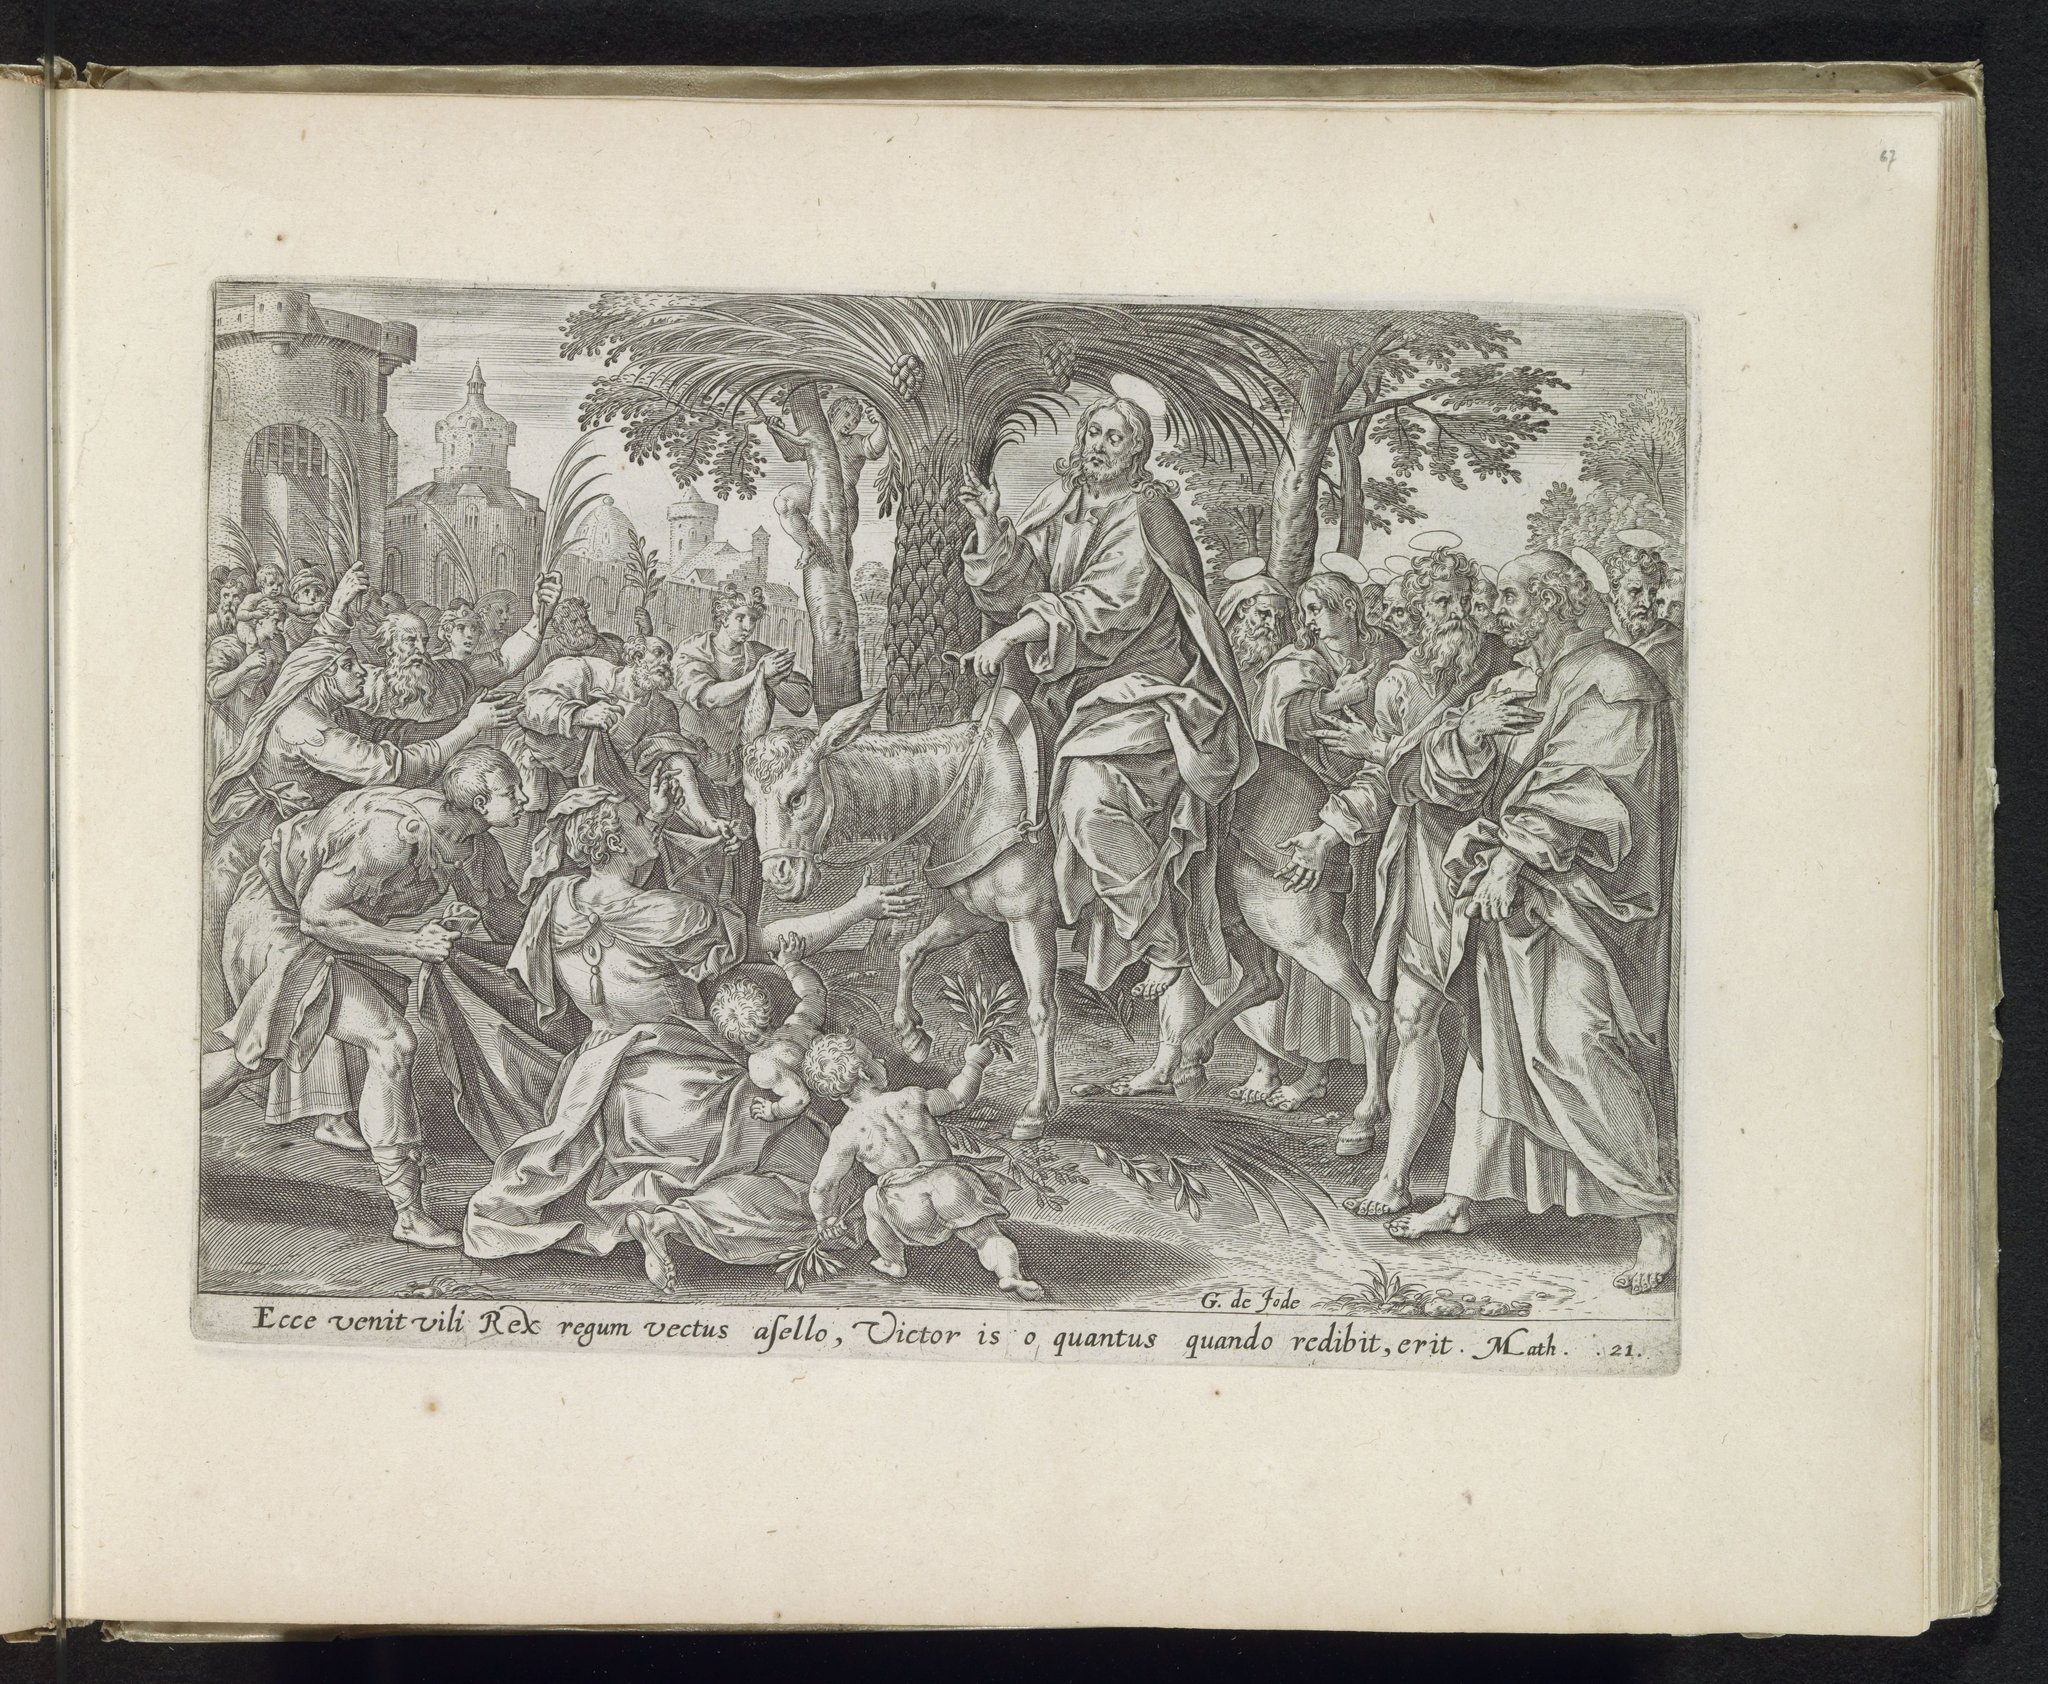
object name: print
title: Intocht in Jeruzalem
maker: gerard de jode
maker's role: draughtsman, print maker, publisher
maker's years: 1508-1591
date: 1585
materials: paper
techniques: engraving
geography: antwerp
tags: entry into jerusalem: people spreading their clothes before christ on the ass, and waving palm branches (matthew 21:1-11, 21:14-16; mark 11:1-11; luke 19:28-40; john 12:12-19)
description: Christus rijdt op een ezel Jeruzalem binnen. De menigte zwaait met palmtakken en legt kleden en mantels voor hem op de grond. Achter Christus lopen zijn apostelen. Onder de voorstelling een verwijzing in het Latijn naar de Bijbeltekst in Mat. 21. Deze prent maakt deel uit van een album.